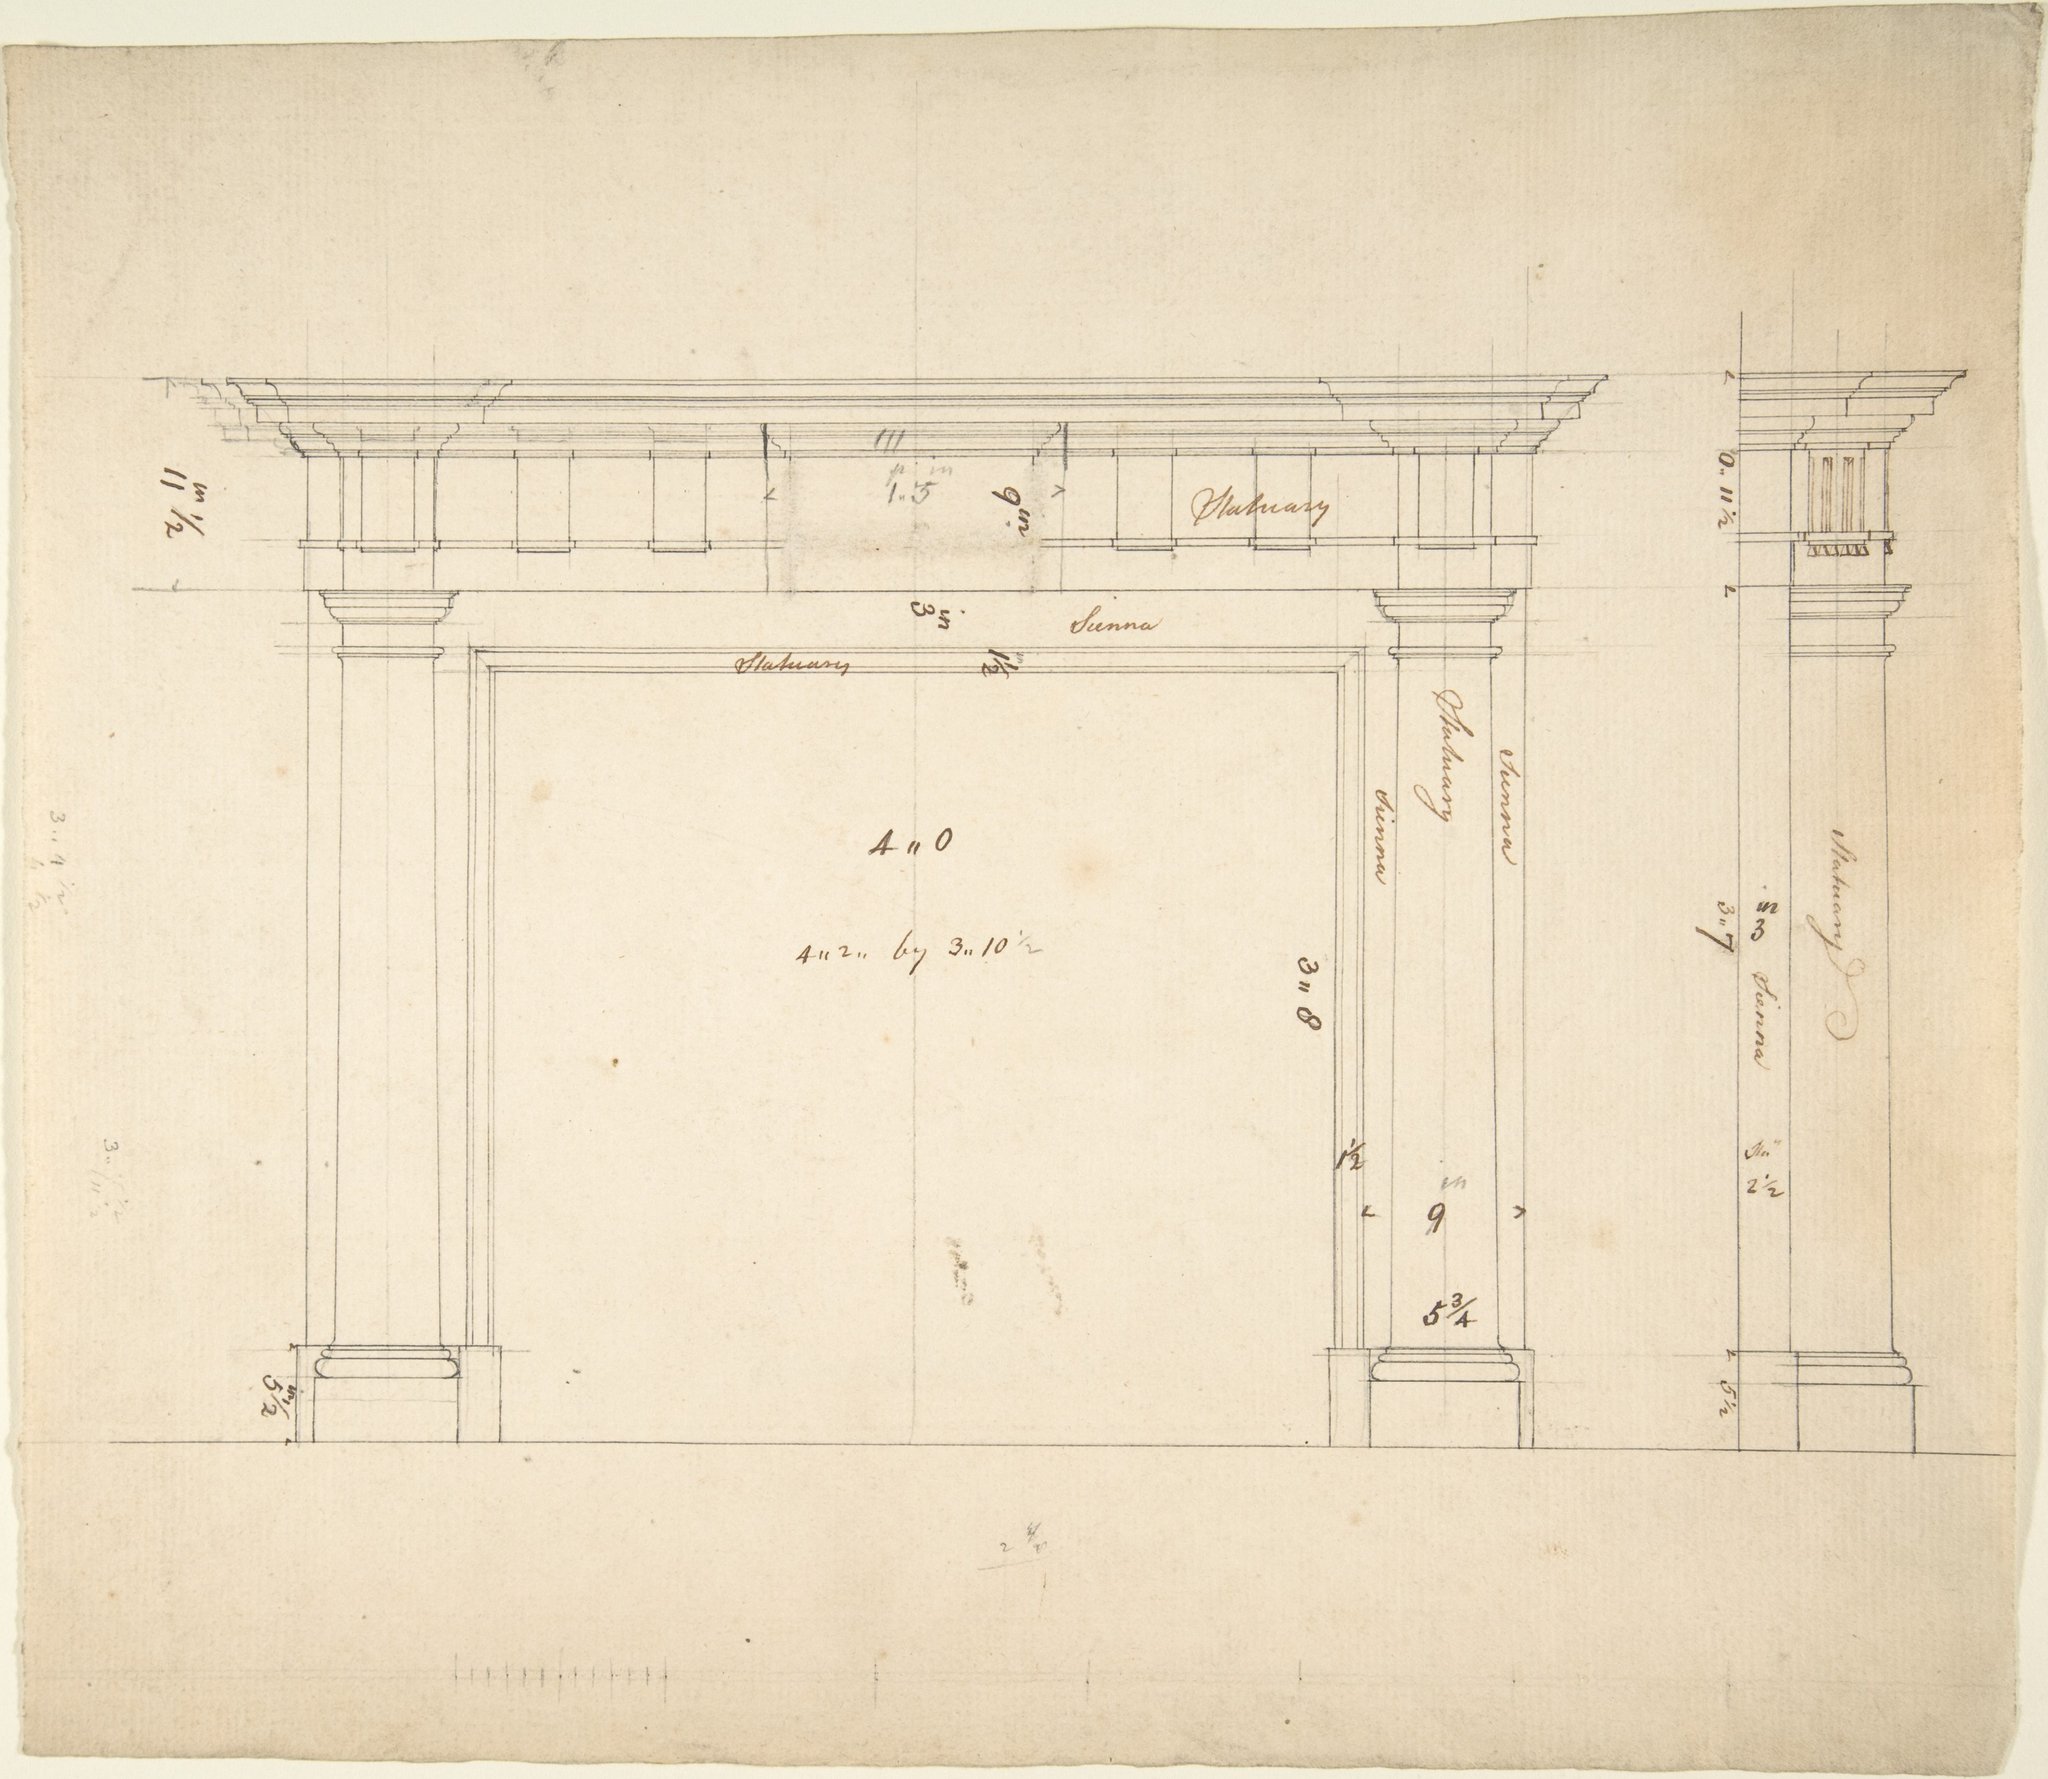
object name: drawing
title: Design for a Chimneypiece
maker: sir william chambers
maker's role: artist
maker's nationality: british, born sweden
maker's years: 1723-1796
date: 1740-1800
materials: ink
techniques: pen